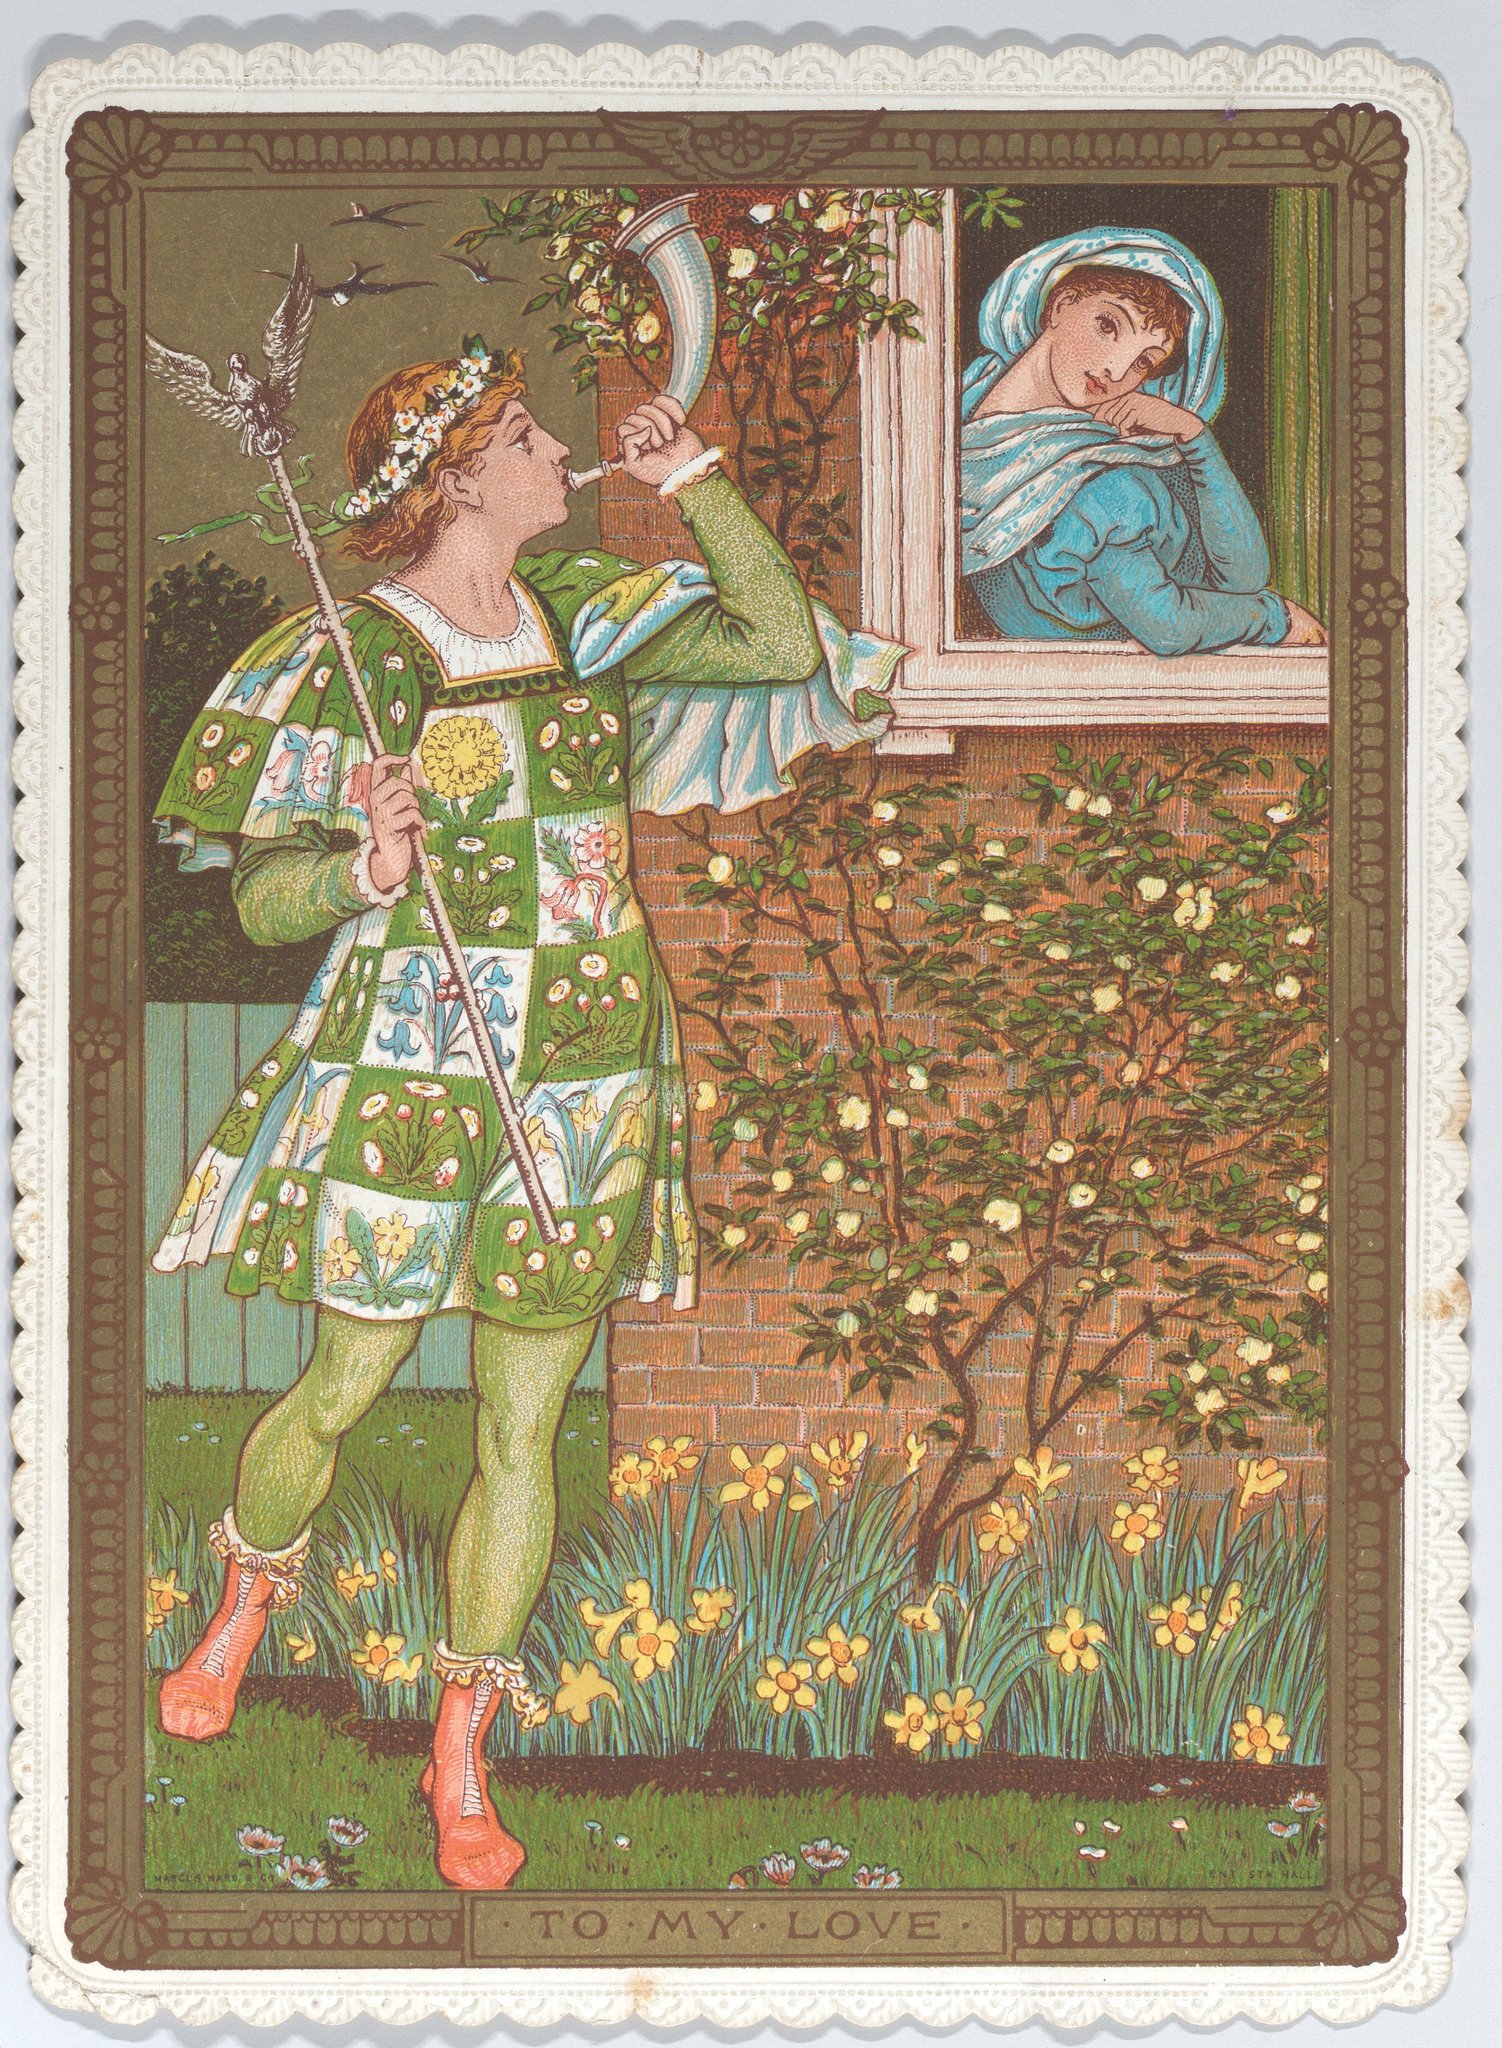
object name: valentine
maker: walter crane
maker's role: artist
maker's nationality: british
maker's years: 1845-1915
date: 1876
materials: gold, graphite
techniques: chromolithography, gilding, lithograph